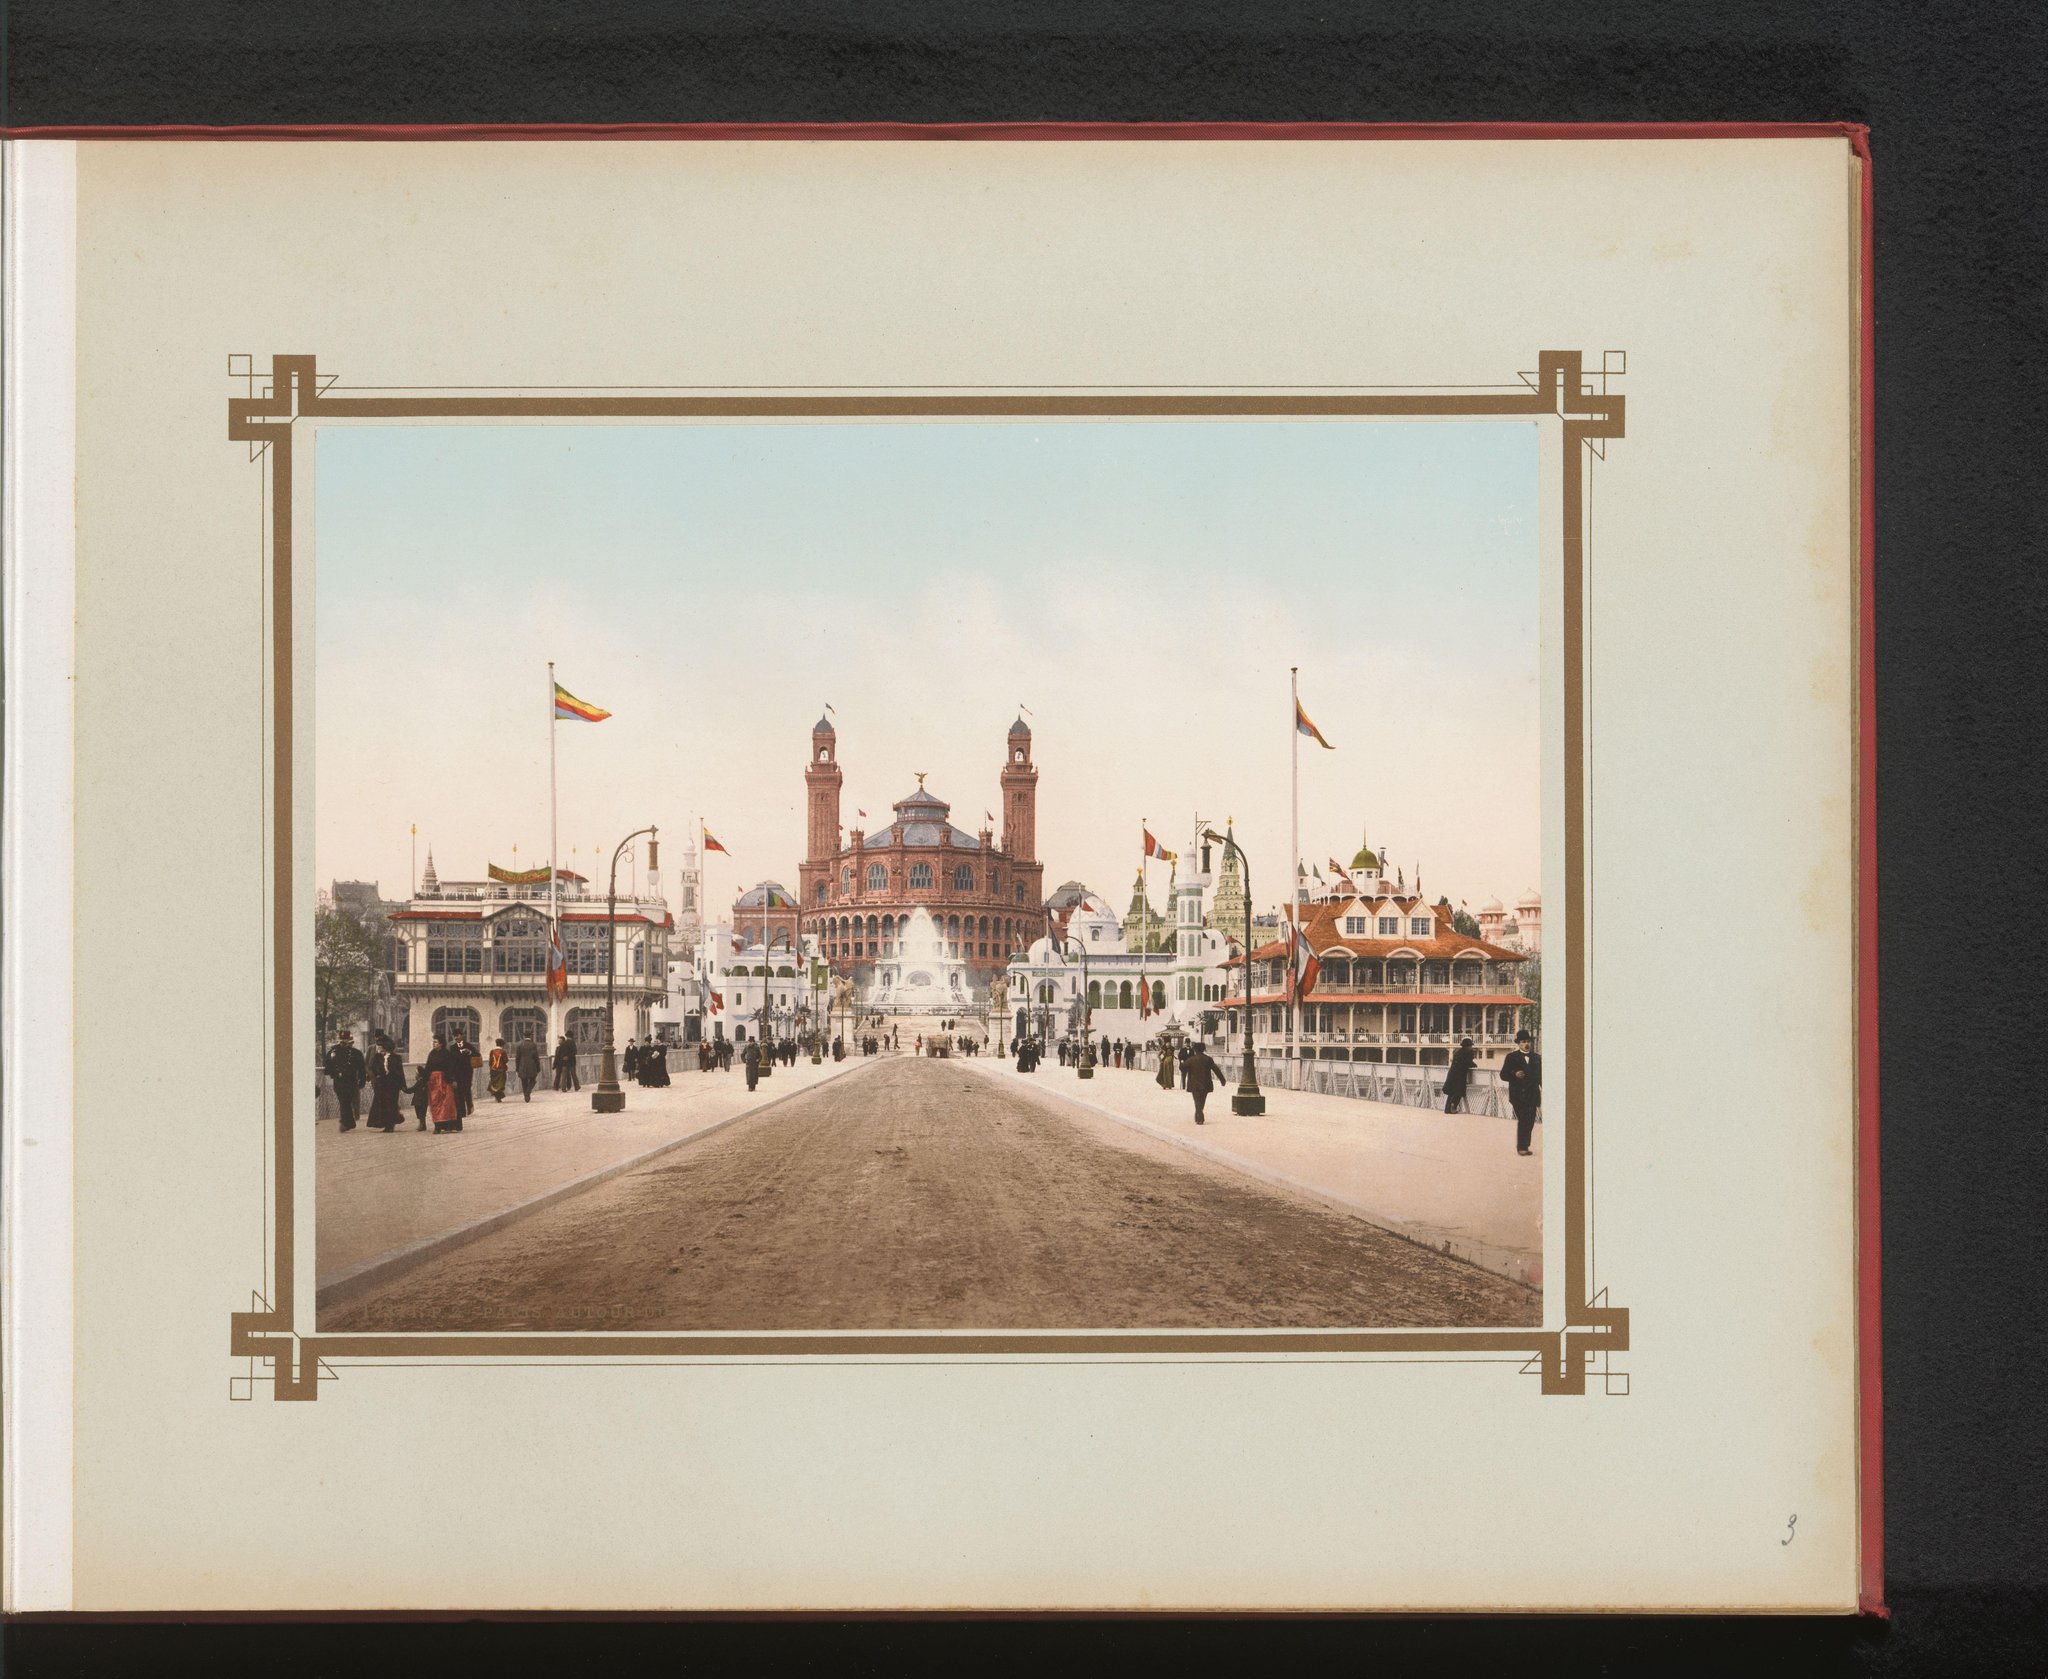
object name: page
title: Palais du Trocadéro tijdens de Wereldtentoonstelling van 1900 te Parijs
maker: Anonymous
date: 1900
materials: paper, photographic process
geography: paris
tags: world fair, world exhibition, civic architecture; edifices; dwellings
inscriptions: inscription: ‘17311. P.Z. Paris autour du Trocadéro’